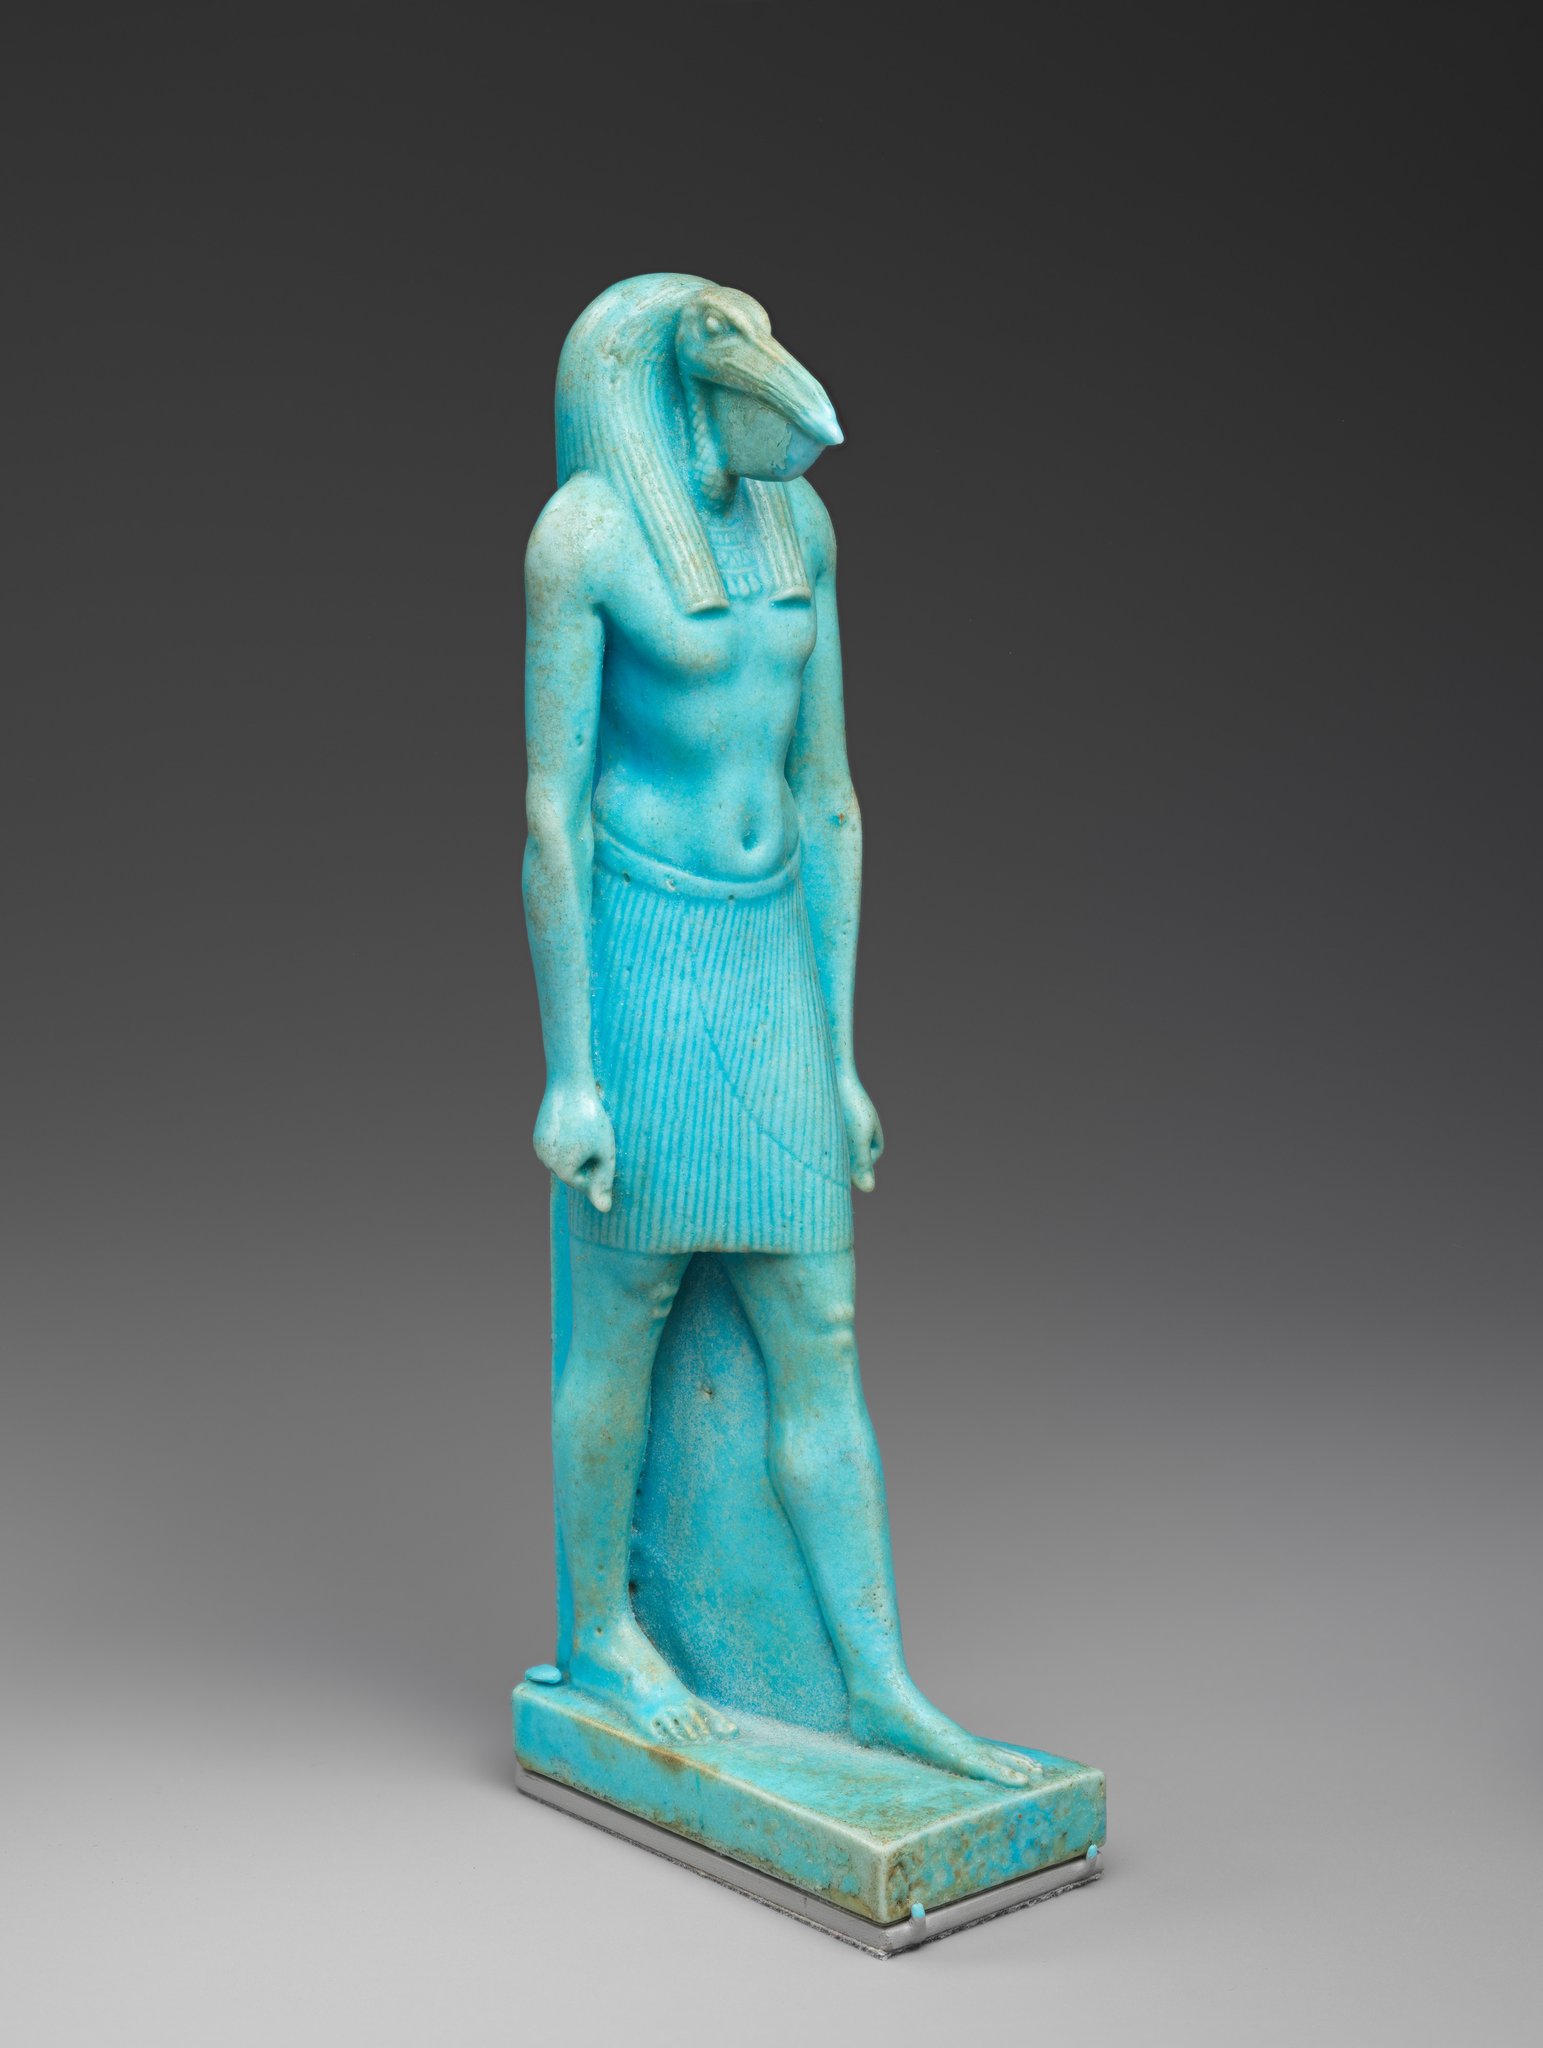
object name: statuette, thoth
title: Striding Thoth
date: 332-330 BCE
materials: faience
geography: egypt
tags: birds,gods